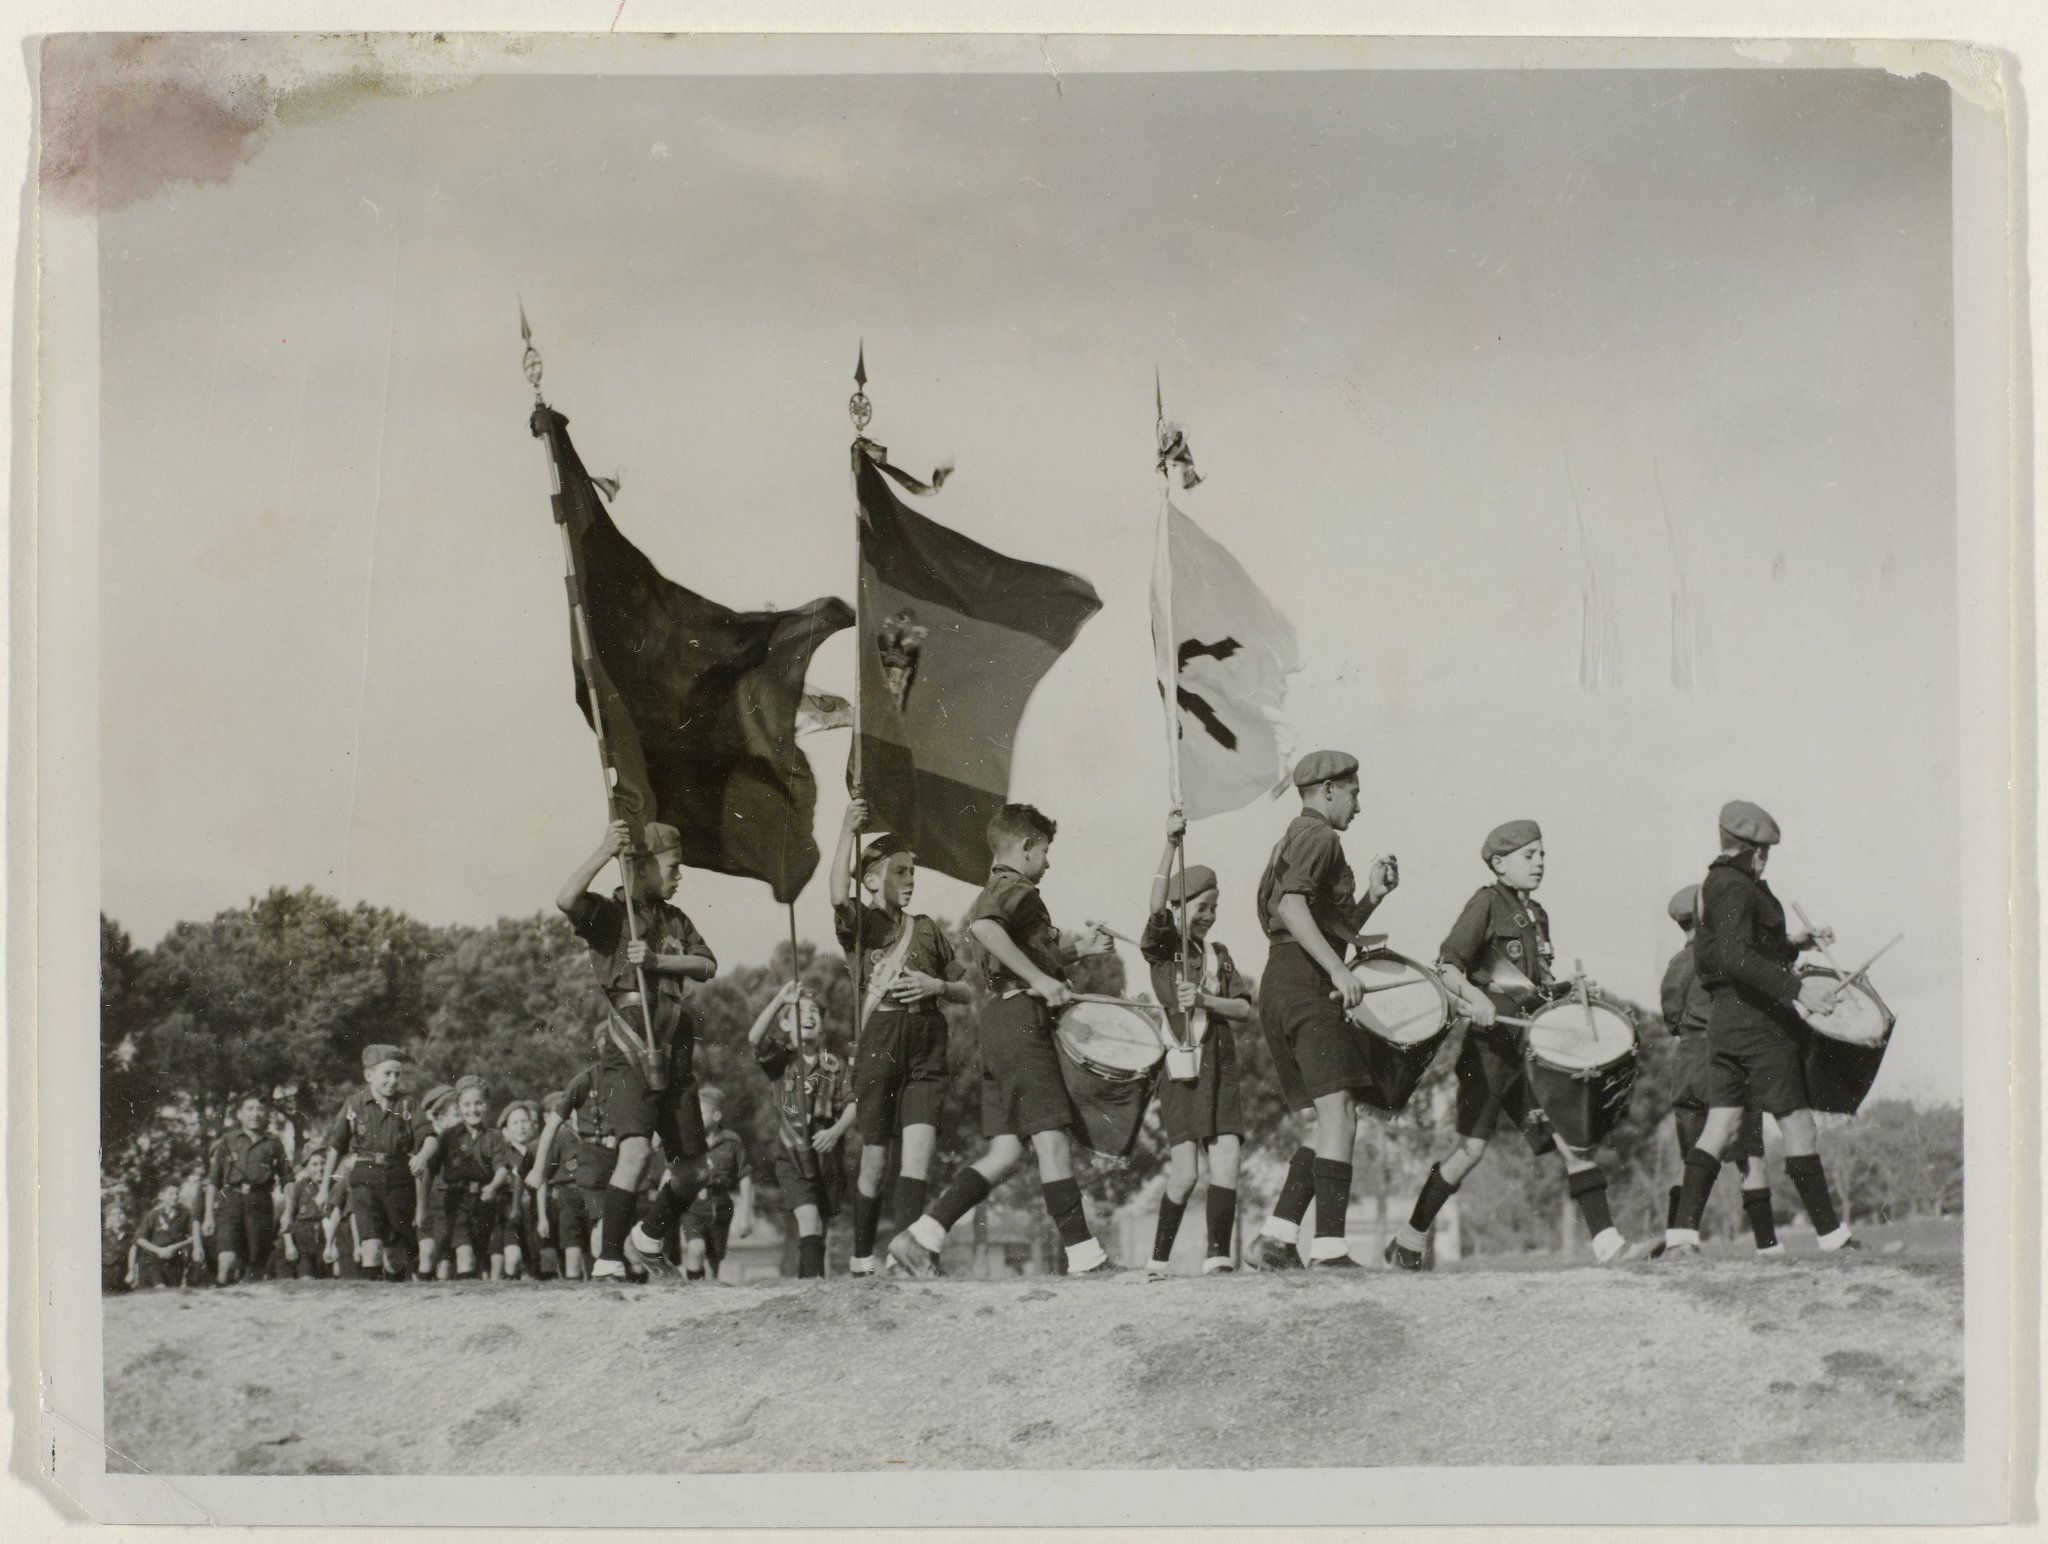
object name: news photograph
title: Die Jungen von Altos de los Leones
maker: Anonymous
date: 1941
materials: photographic support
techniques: gelatin silver print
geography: amsterdam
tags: spain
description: Parade met vaandels en trommels door leden van de Spaanse fascistische jeugdvereniging in de bergen van de Altos de los Leones, 23 januari 1941. Op de achterzijde twee stempels en blaadje met perstekst in het Duits.